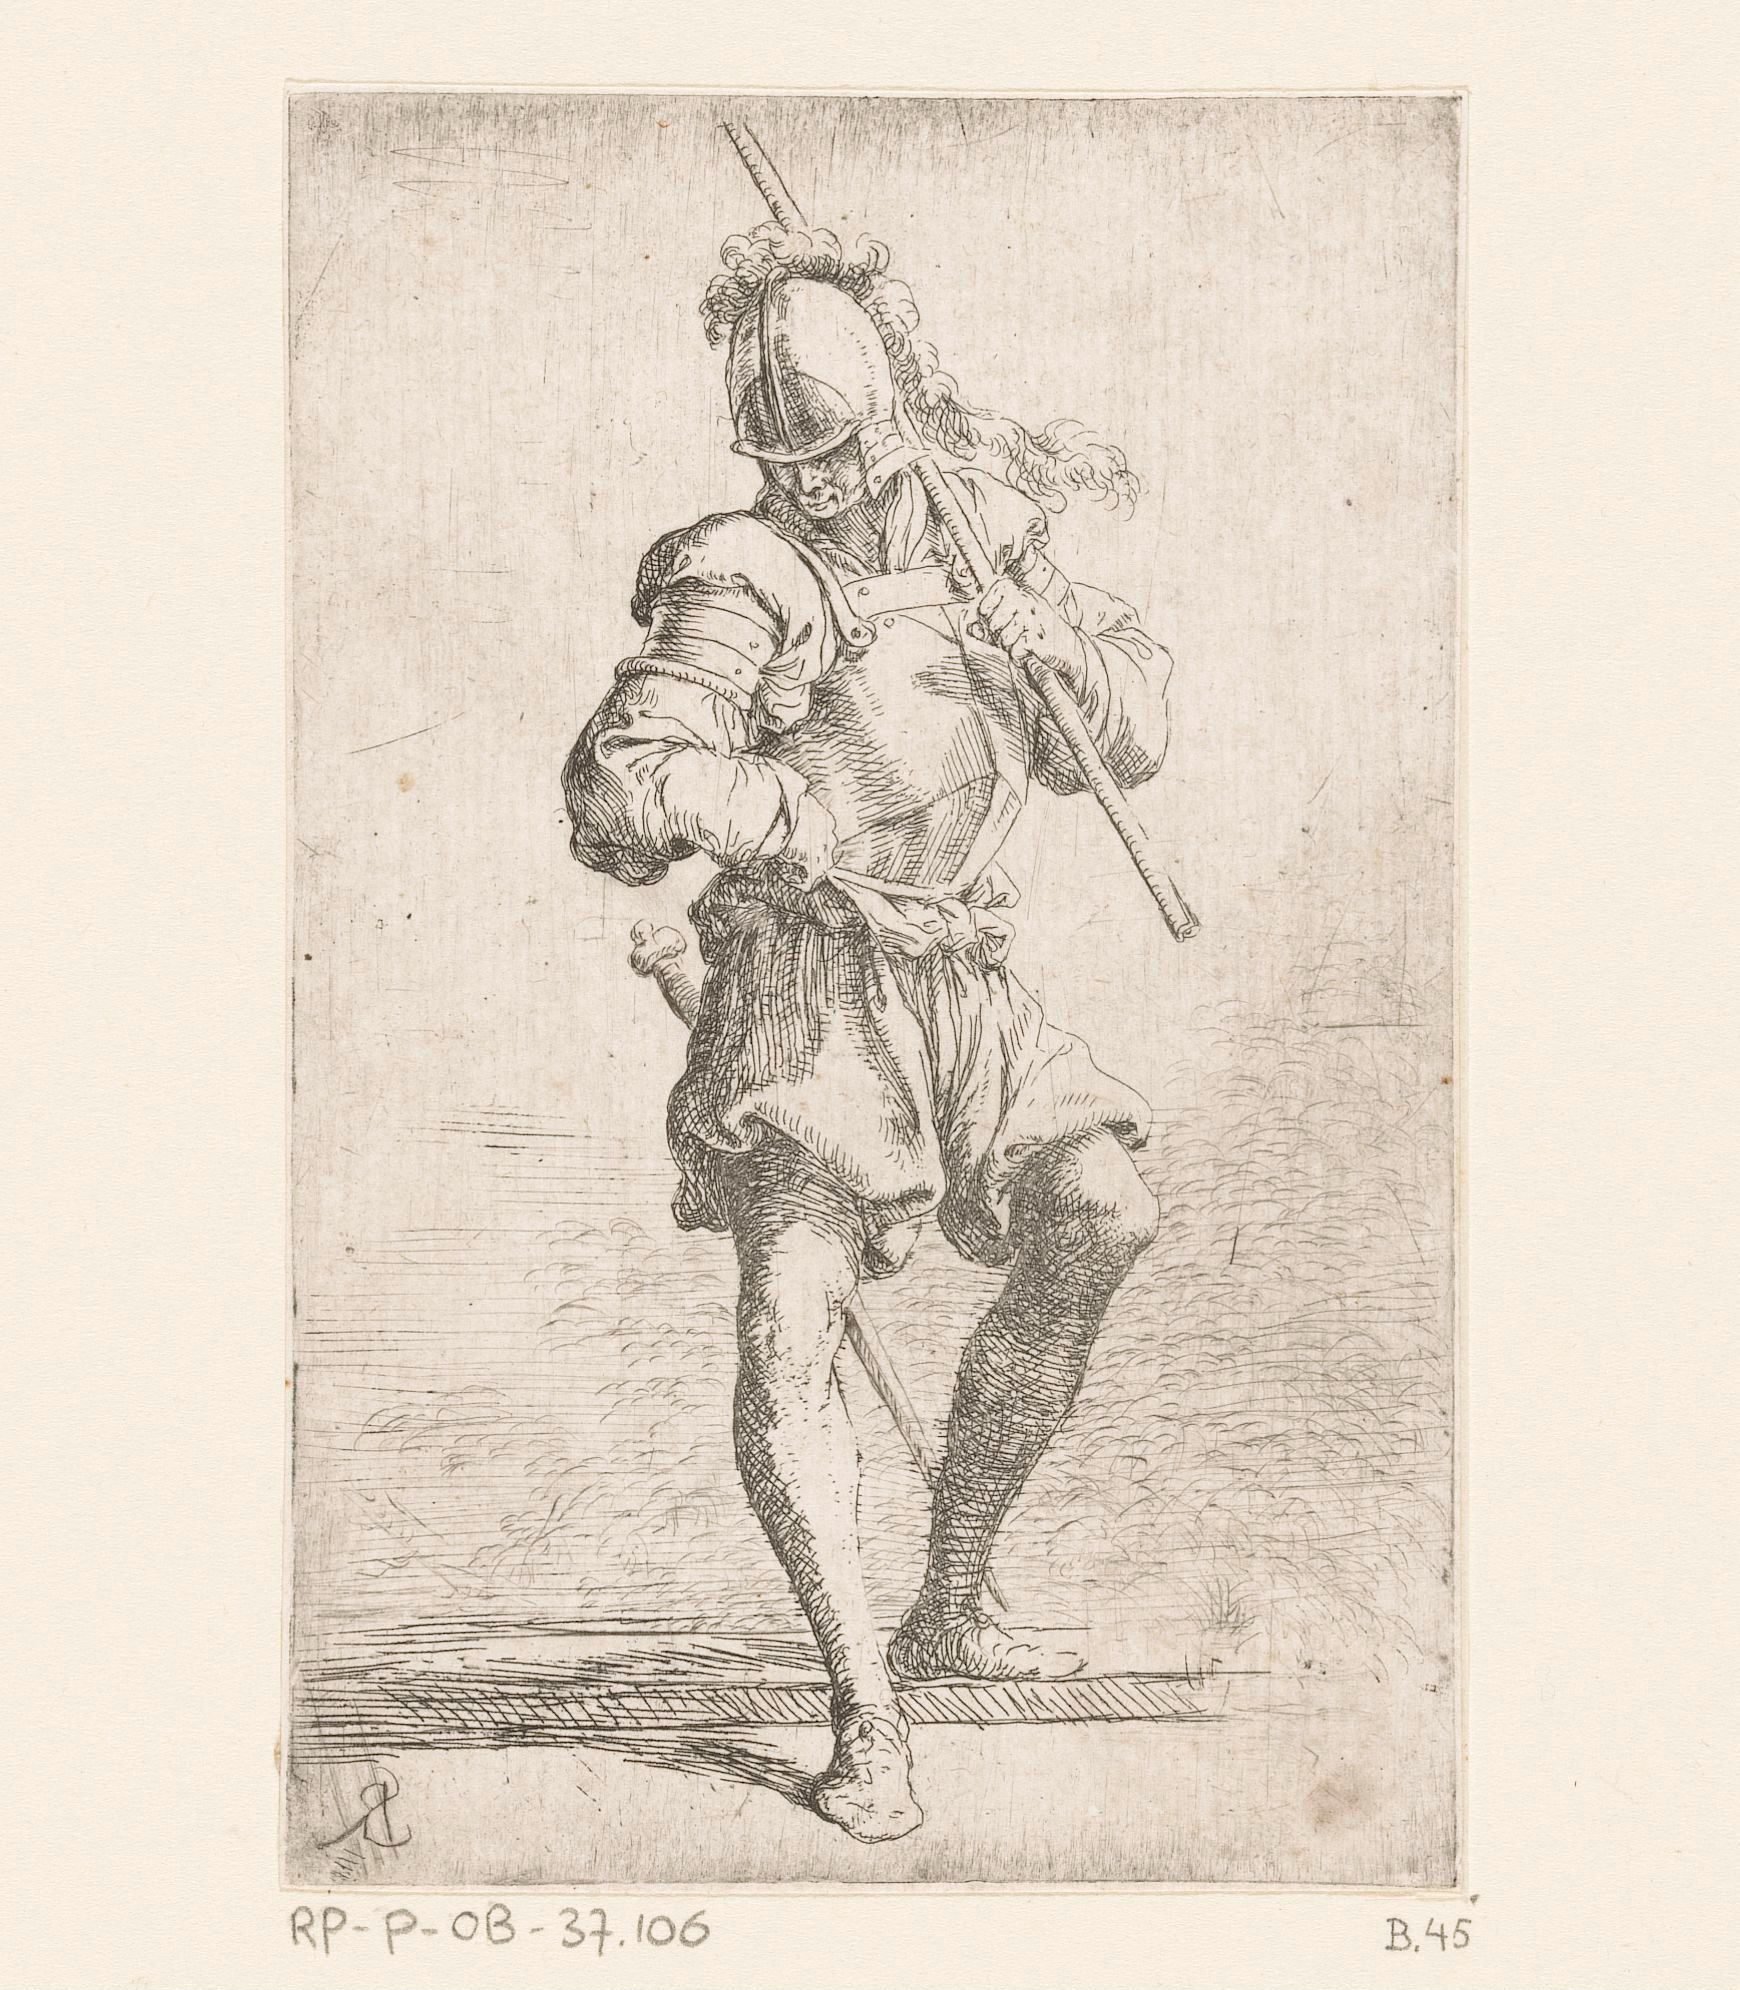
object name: print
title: Figurine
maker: salvator rosa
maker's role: draughtsman, painter, print maker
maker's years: 1615-1673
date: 1656-1657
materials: paper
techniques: drypoint, etching, intaglio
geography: italy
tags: walking-stick, staff, the soldier; the soldier's life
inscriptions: collector's mark: Lugt 240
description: Deze prent maakt deel uit van de serie 'Figurine', bestaande uit een titelprent en 80 prenten van klein formaat met voorstellingen van mannelijke en vrouwelijke figuren. Rosa produceerde de serie waarschijnlijk gedurende de jaren 1656 en 1657.